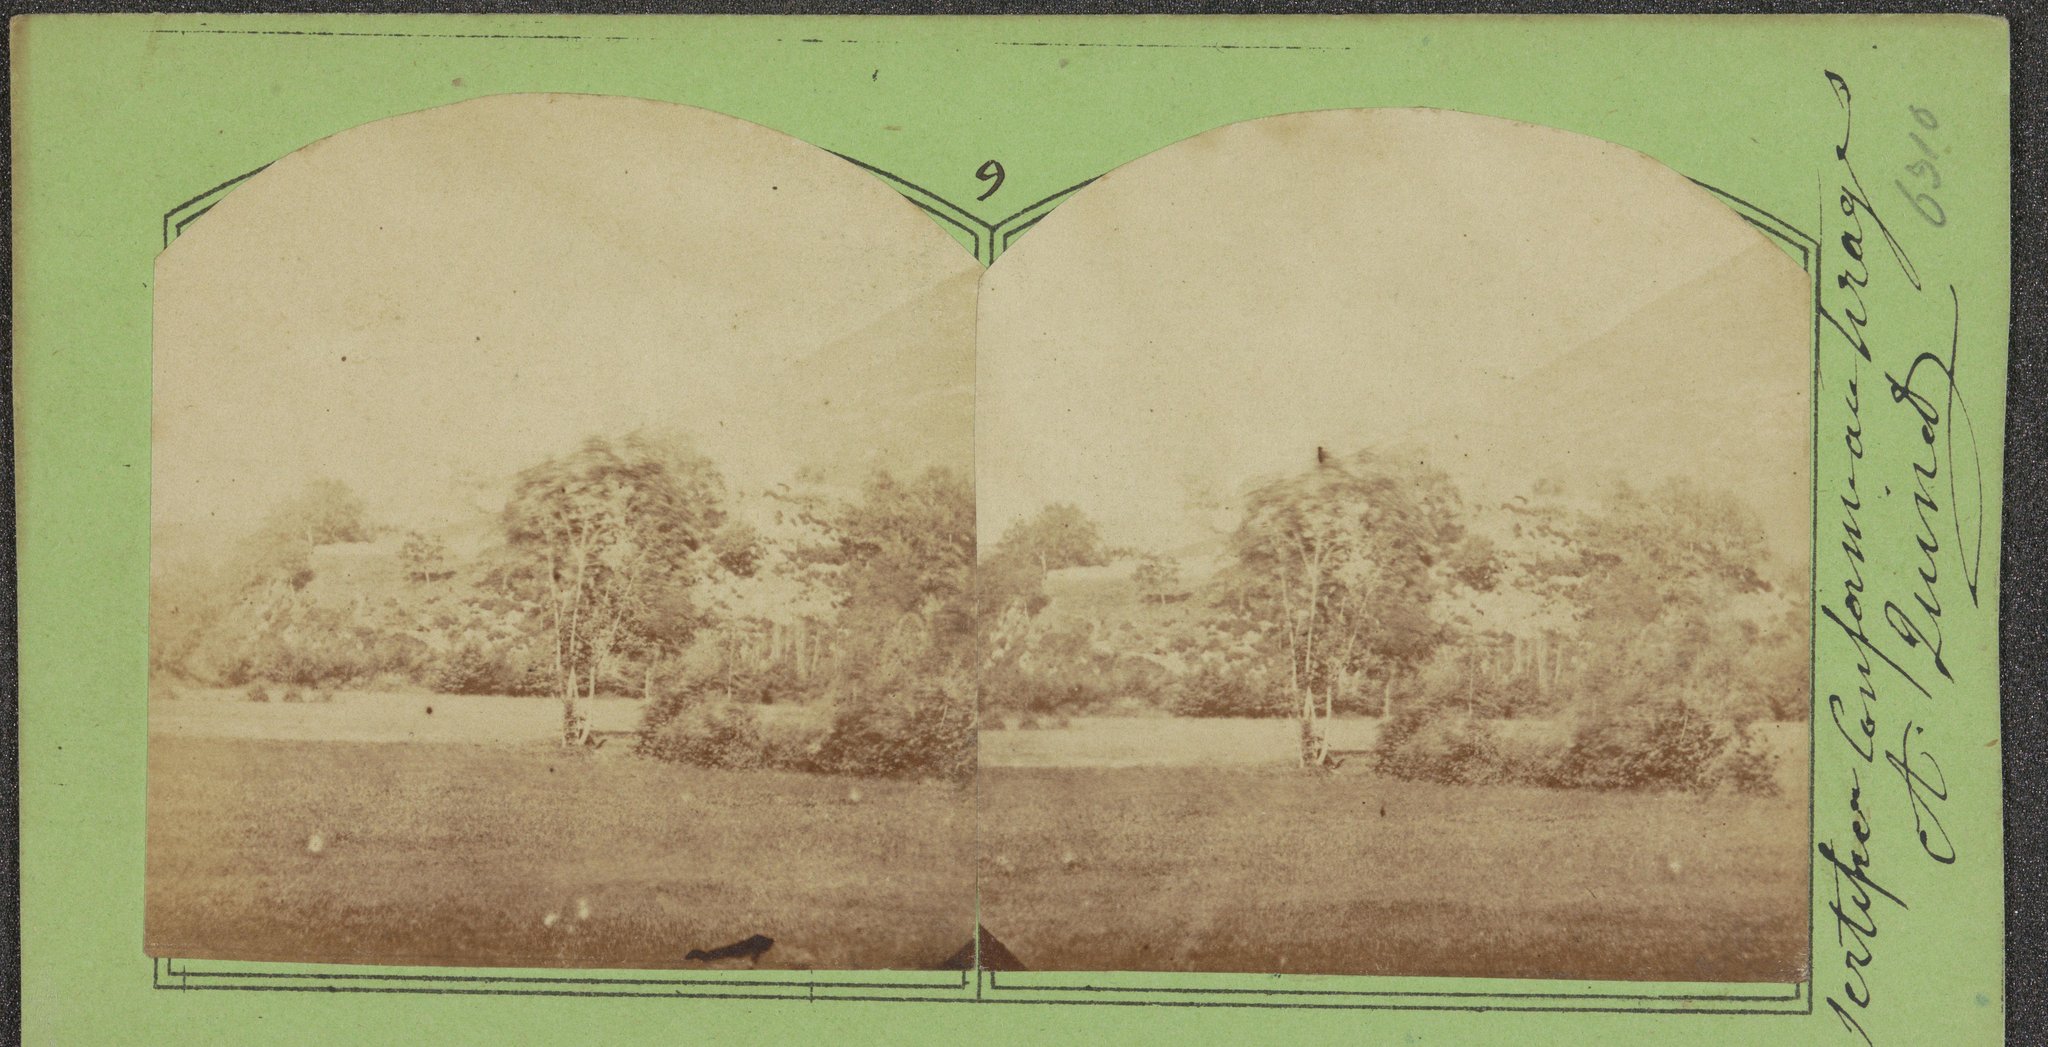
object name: stereograph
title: Grasveld met bomen en op de achtergrond de Alpen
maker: achille quinet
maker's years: 1831-1900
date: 1860-1880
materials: cardboard, paper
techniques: albumen print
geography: alps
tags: mountains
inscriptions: signature: ‘Sertifier conforme au tirages // A Quinet’